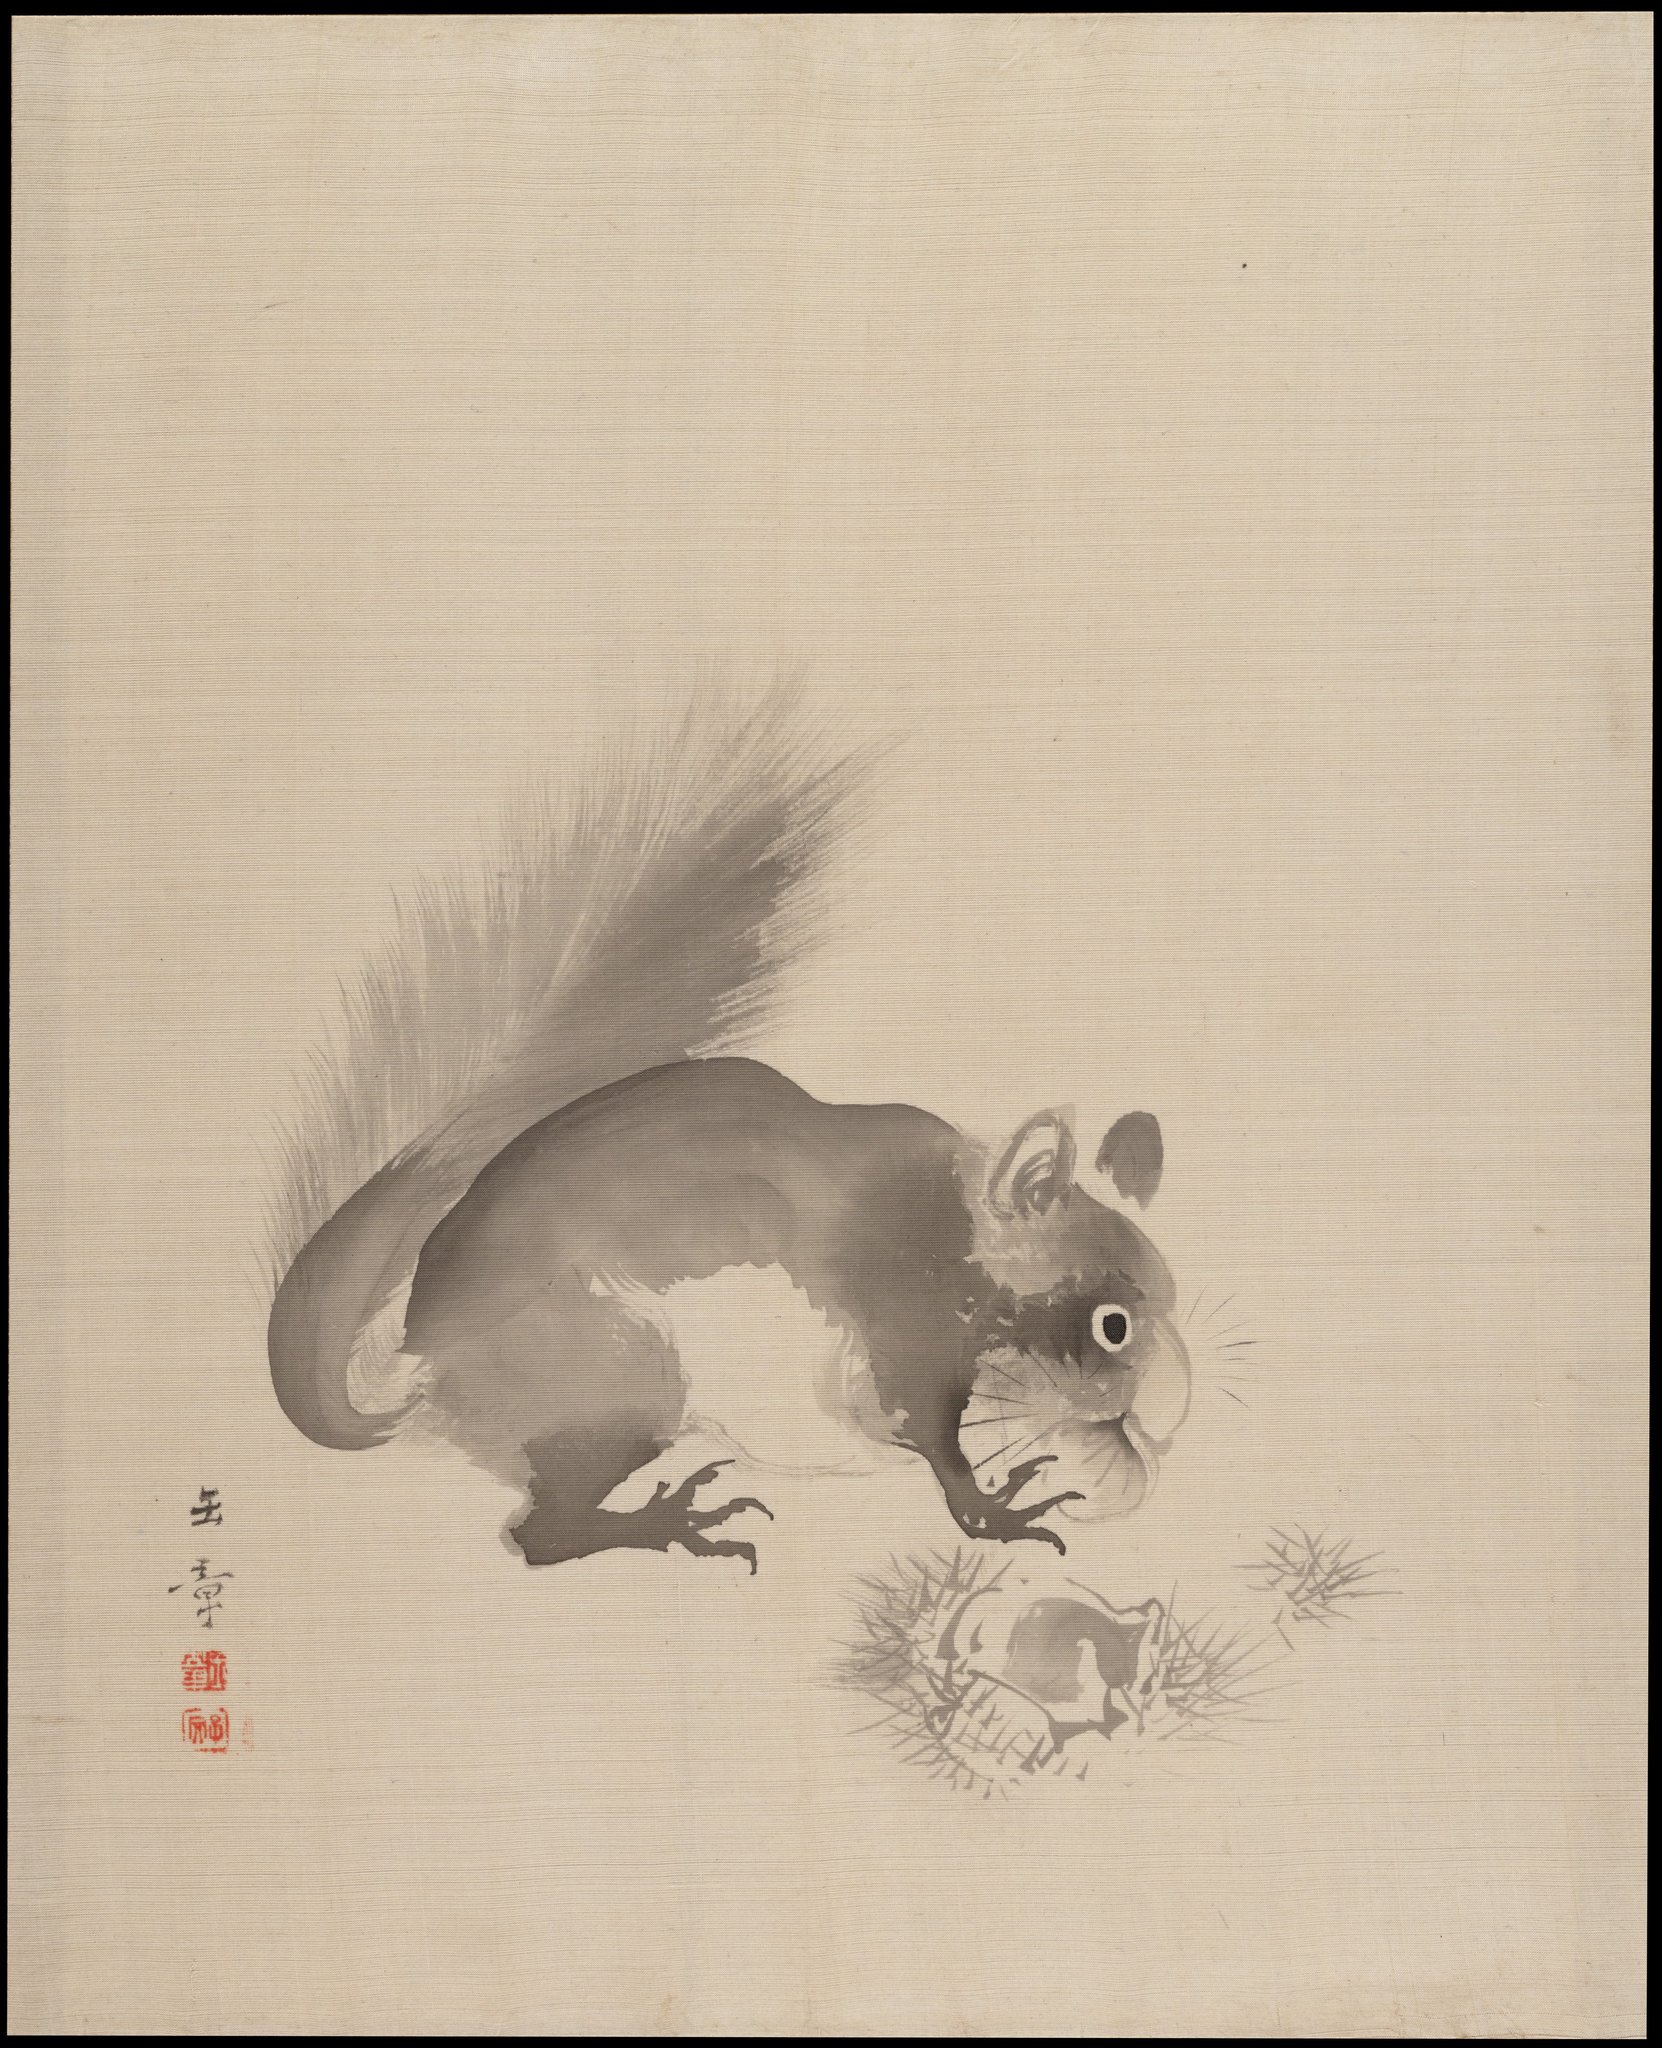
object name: album leaf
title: Squirrel Eating Chestnuts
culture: japanese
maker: kawabata gyokushō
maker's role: artist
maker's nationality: japanese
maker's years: 1842-1913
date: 1887-1892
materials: ink, silk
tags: squirrels